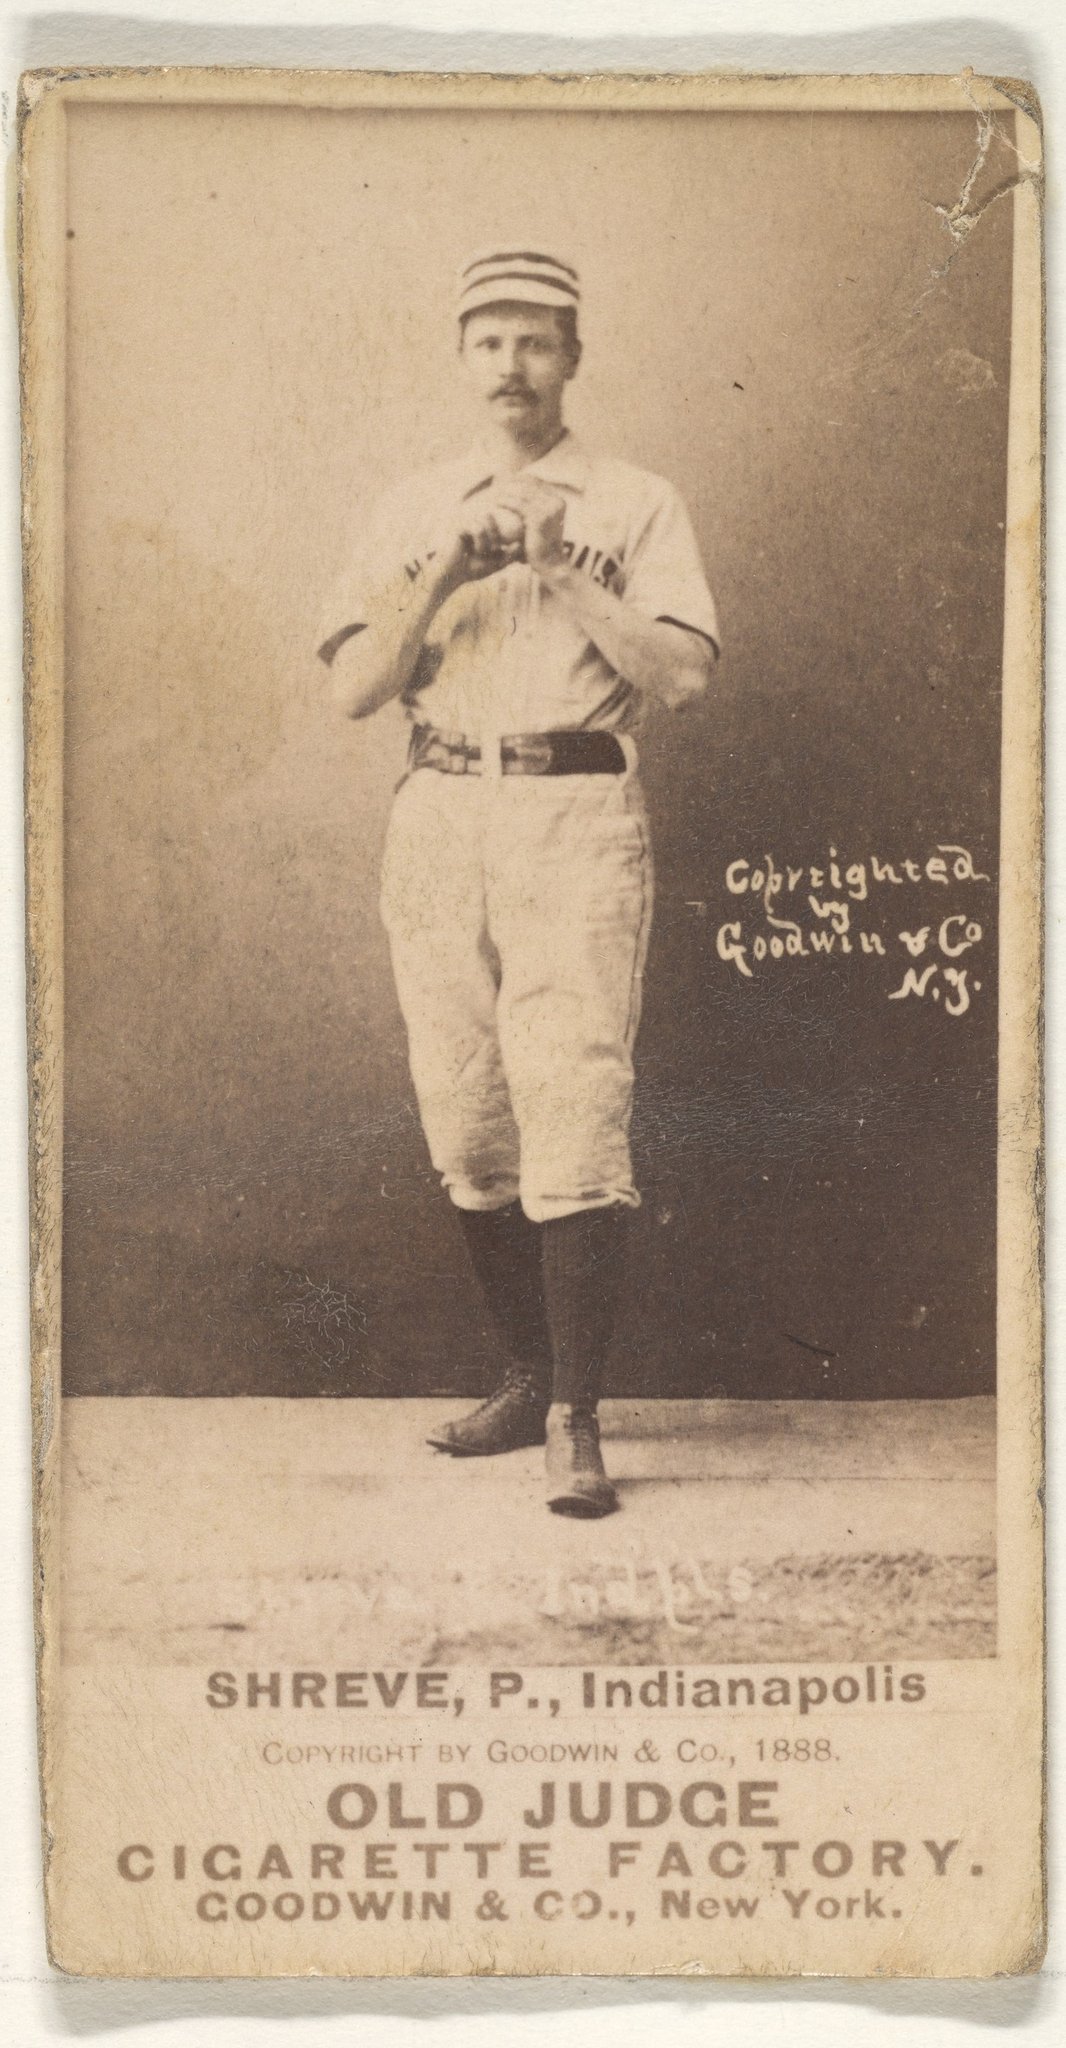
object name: baseball card, photograph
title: Lev Shreve, Pitcher, Indianapolis, from the Old Judge series (N172) for Old Judge Cigarettes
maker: goodwin & company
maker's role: publisher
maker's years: 1850-1950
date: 1888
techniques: albumen silver print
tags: men,portraits,baseball,athletes